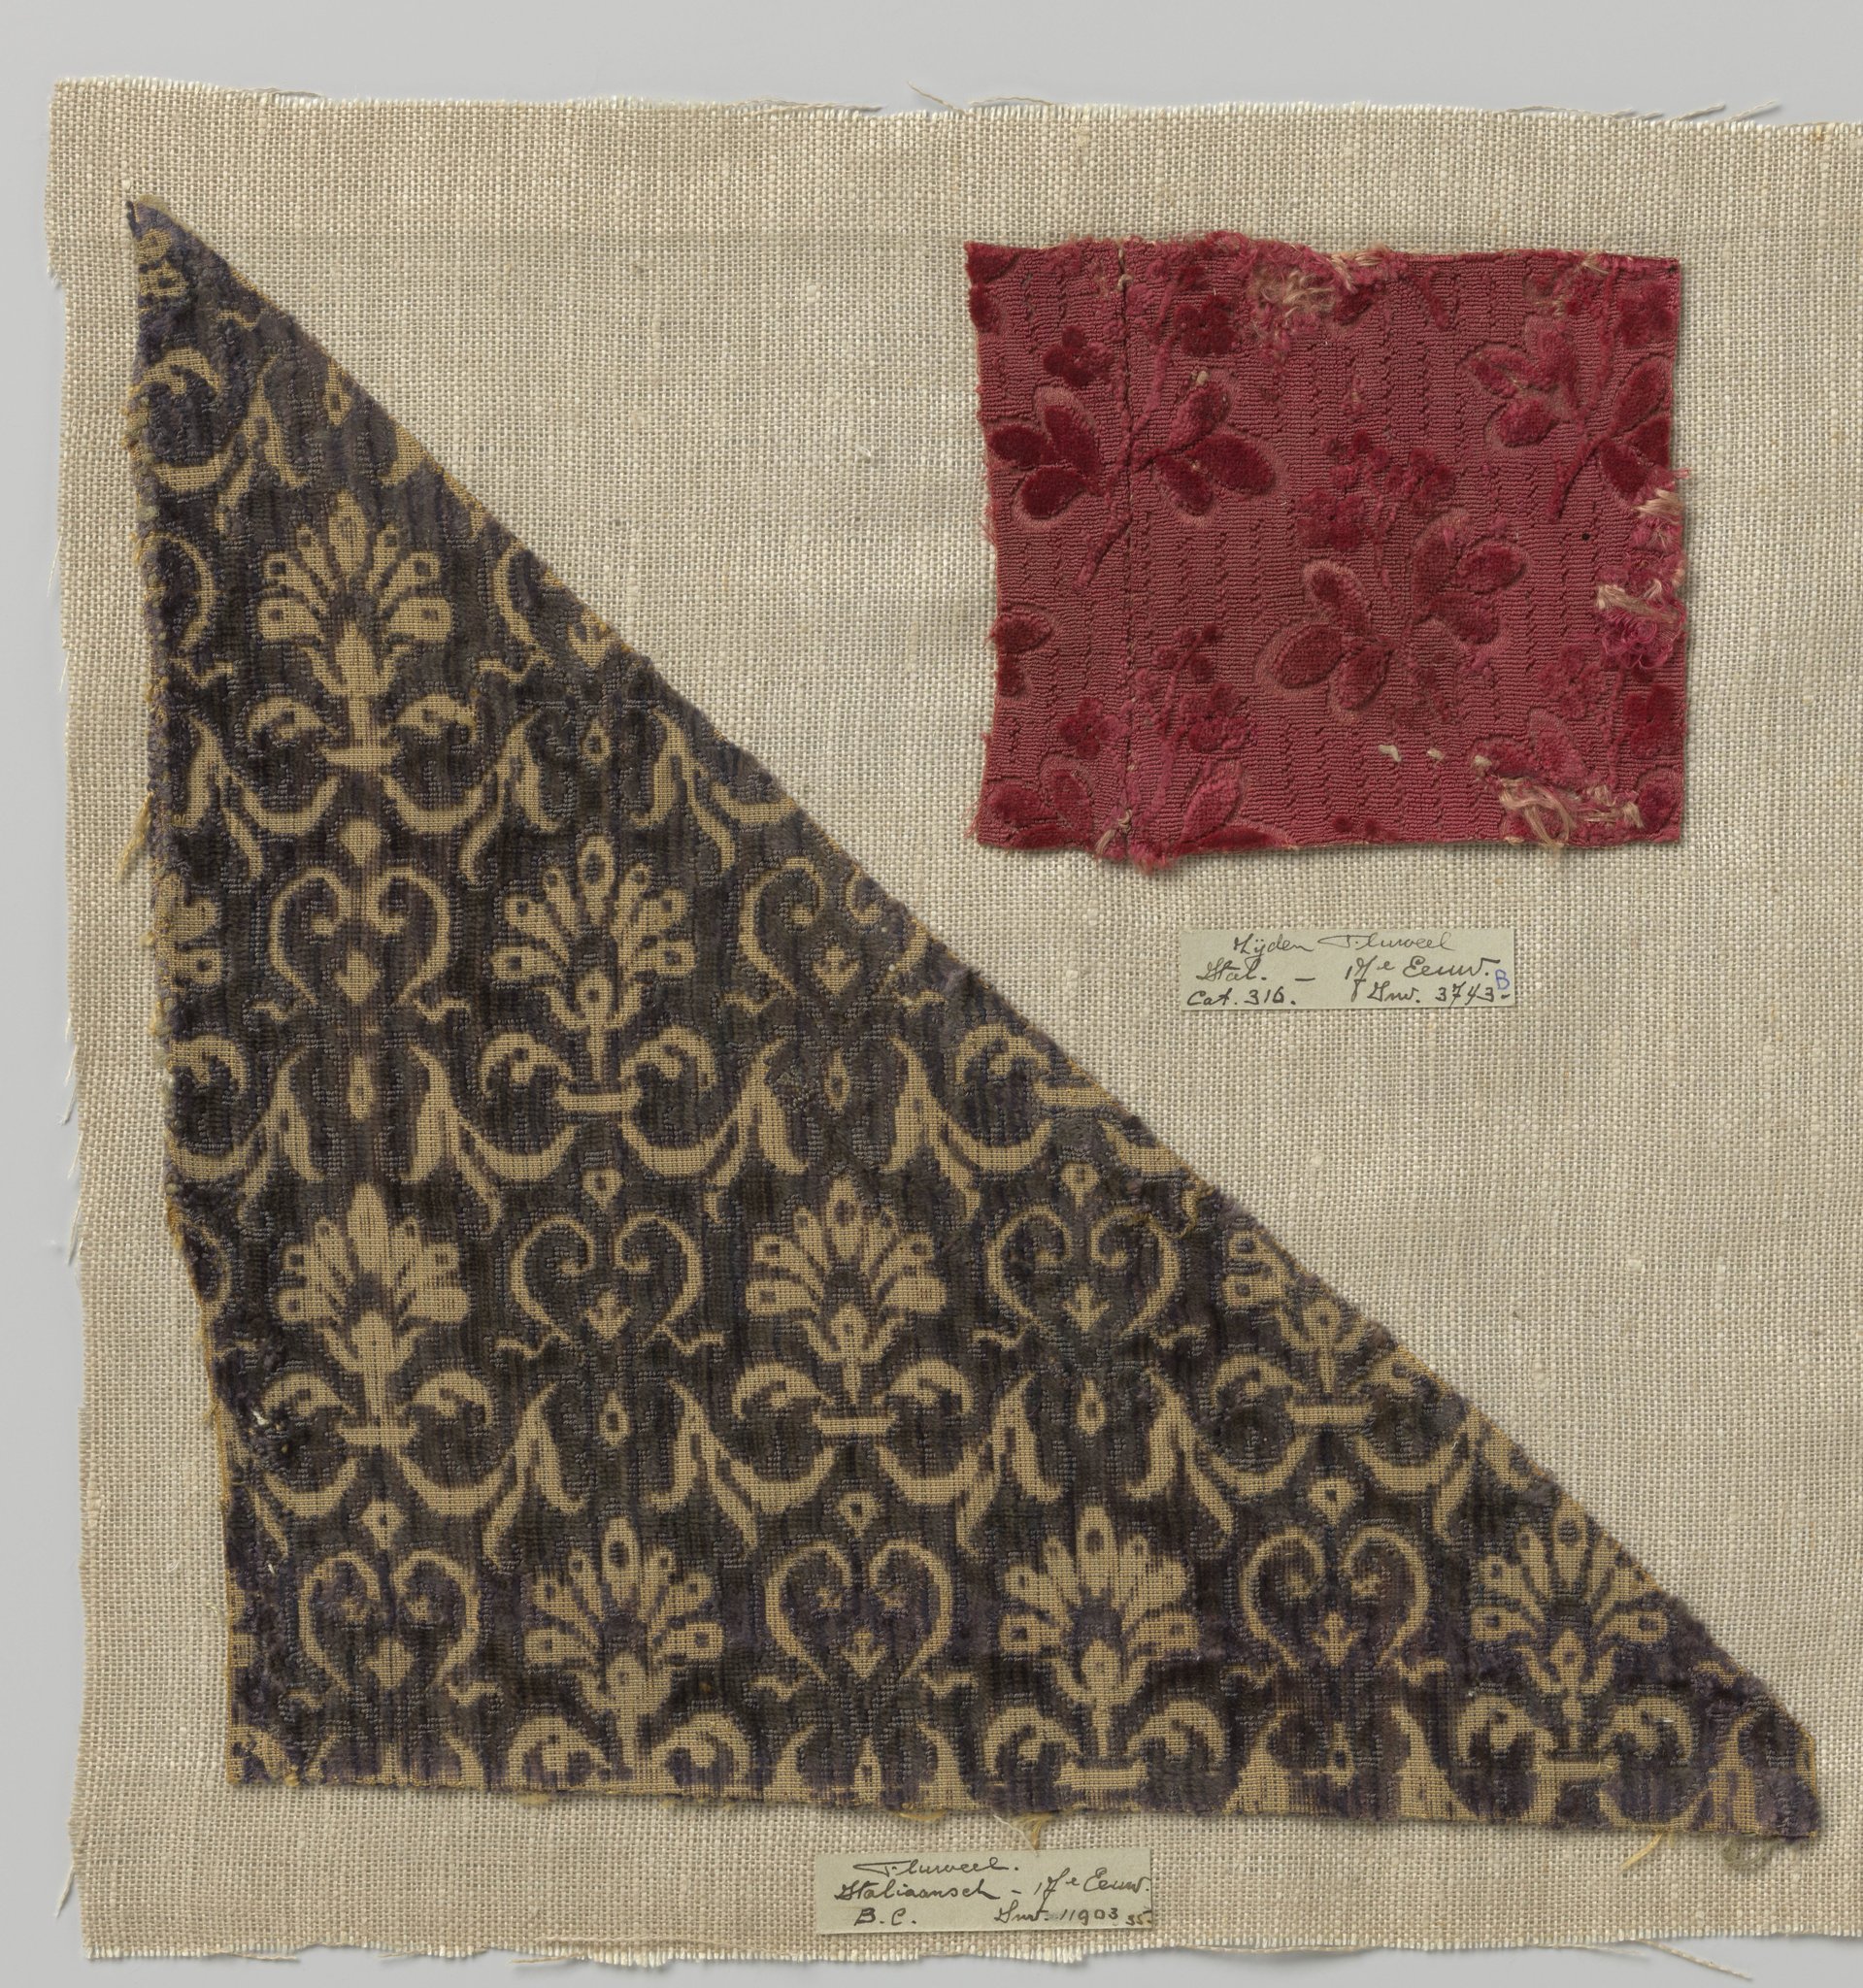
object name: zijdefluweel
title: Fragment zijdefluweel met palmetten en arabesken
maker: Anonymous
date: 1600-1699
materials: ciselé velvet, silk, velvet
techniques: weave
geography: italy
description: Een fragment van zijdefluweel met uitsparingen. Op een bruin, gele zijden grond zijn in paars fluweel horizontaal gerijde palmetten en arabesken getekend.